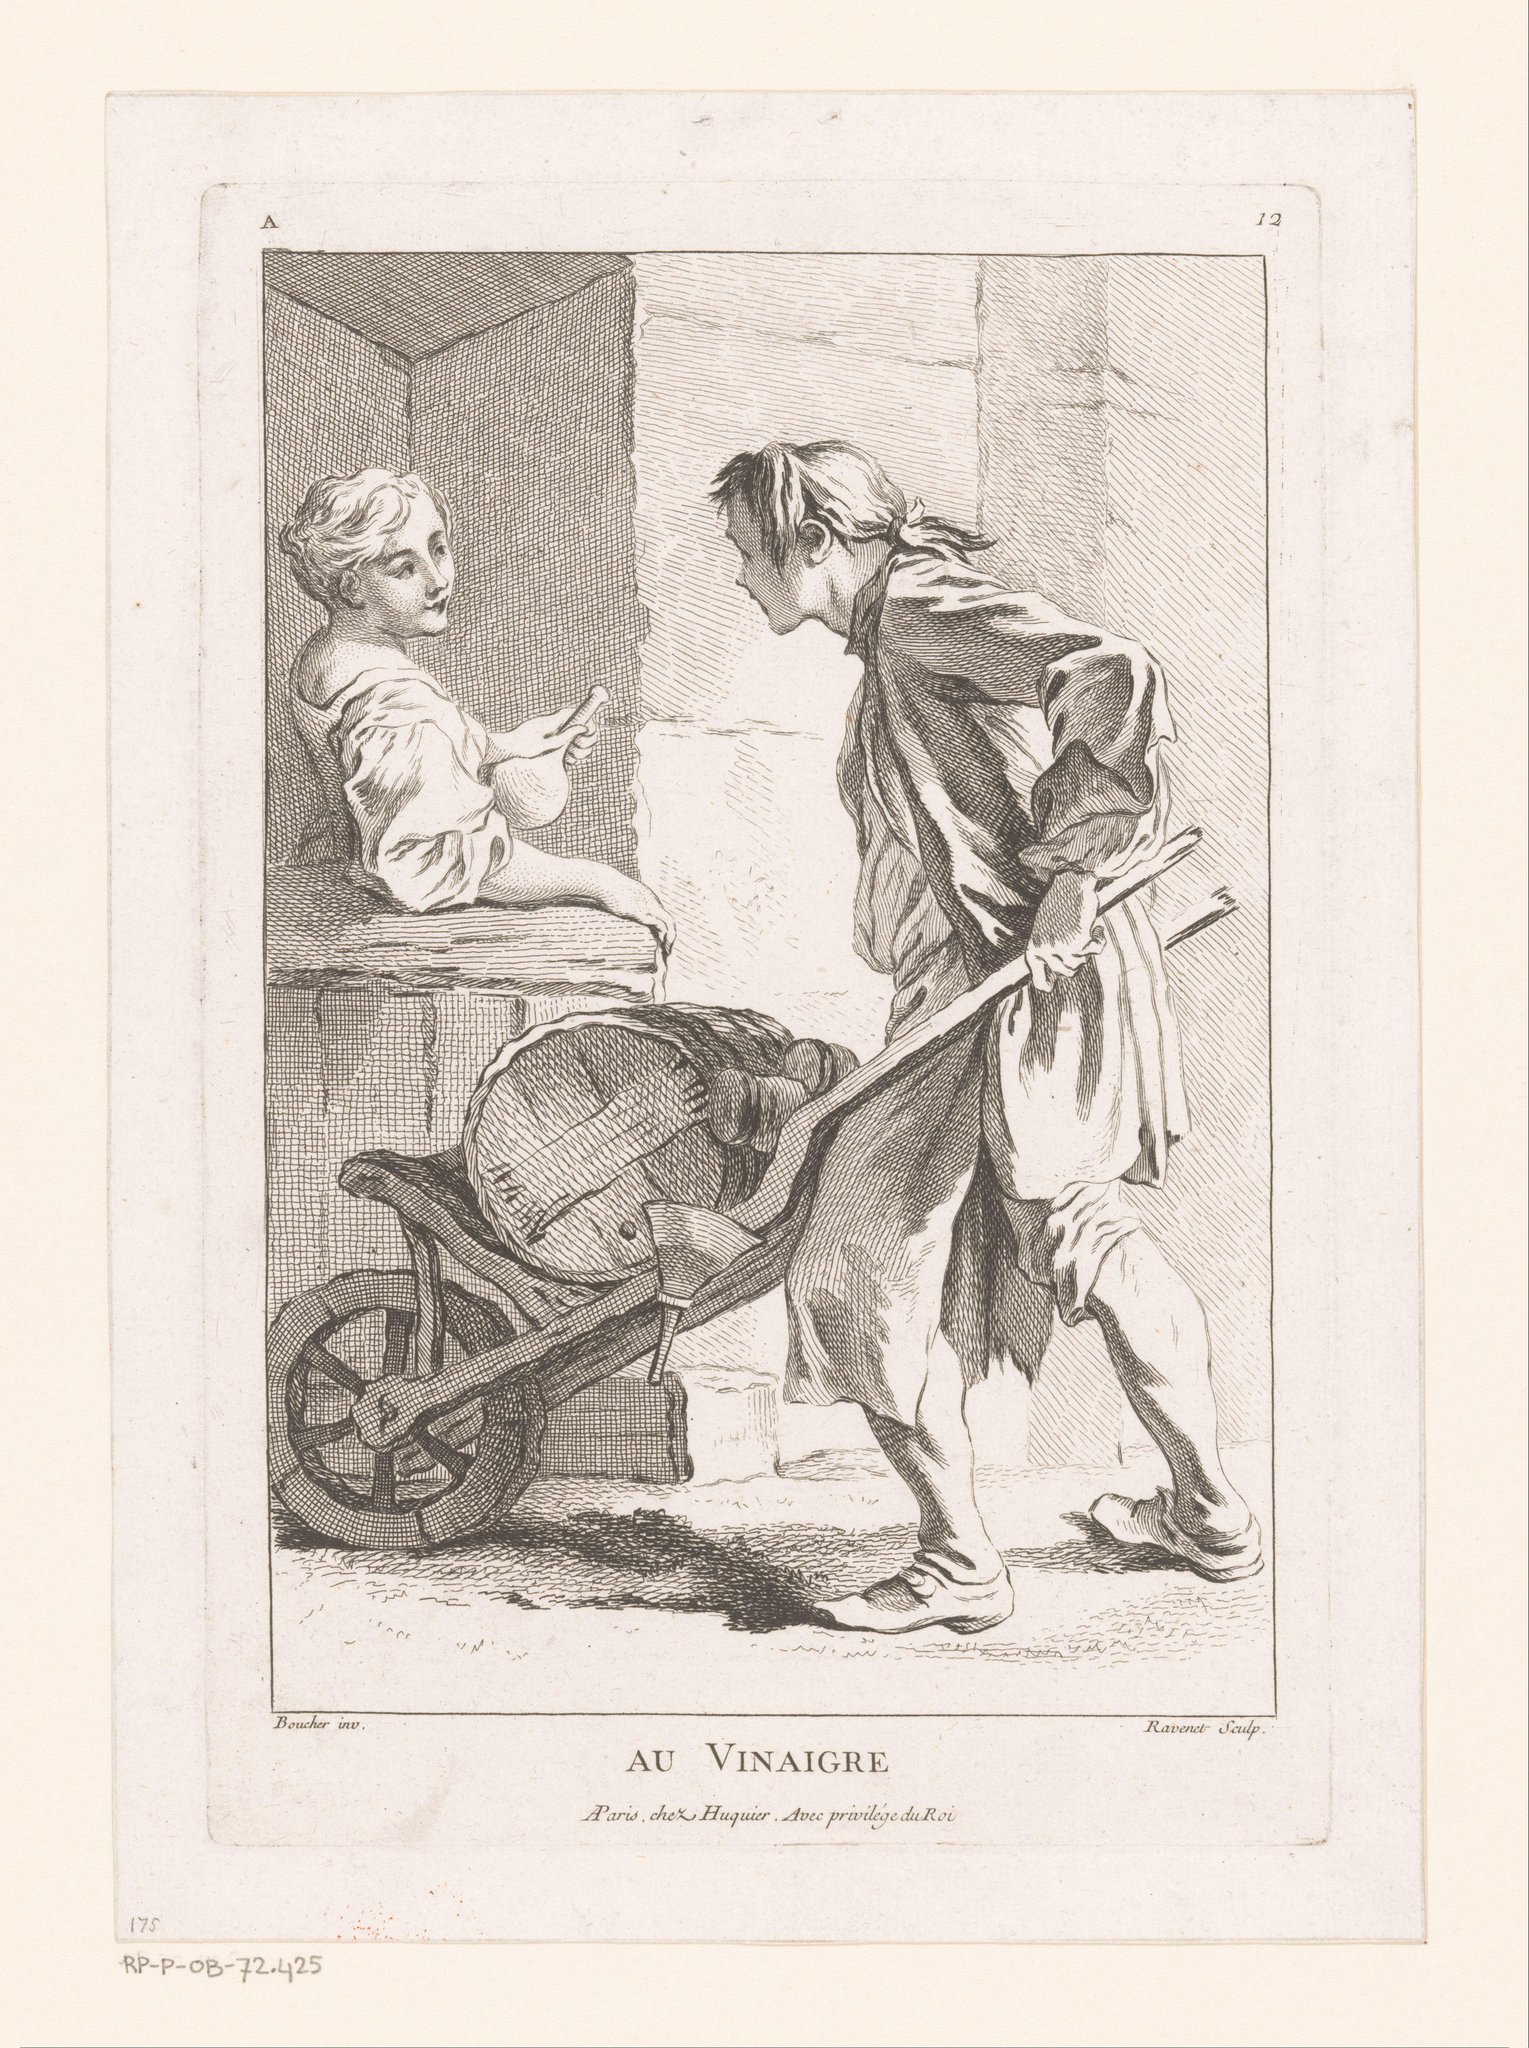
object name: print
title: Azijnverkoper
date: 1716-1772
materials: paper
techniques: engraving, etching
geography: france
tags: vinegar, 'cris de paris', cries of london, etc.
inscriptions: collector's mark: Lugt 240